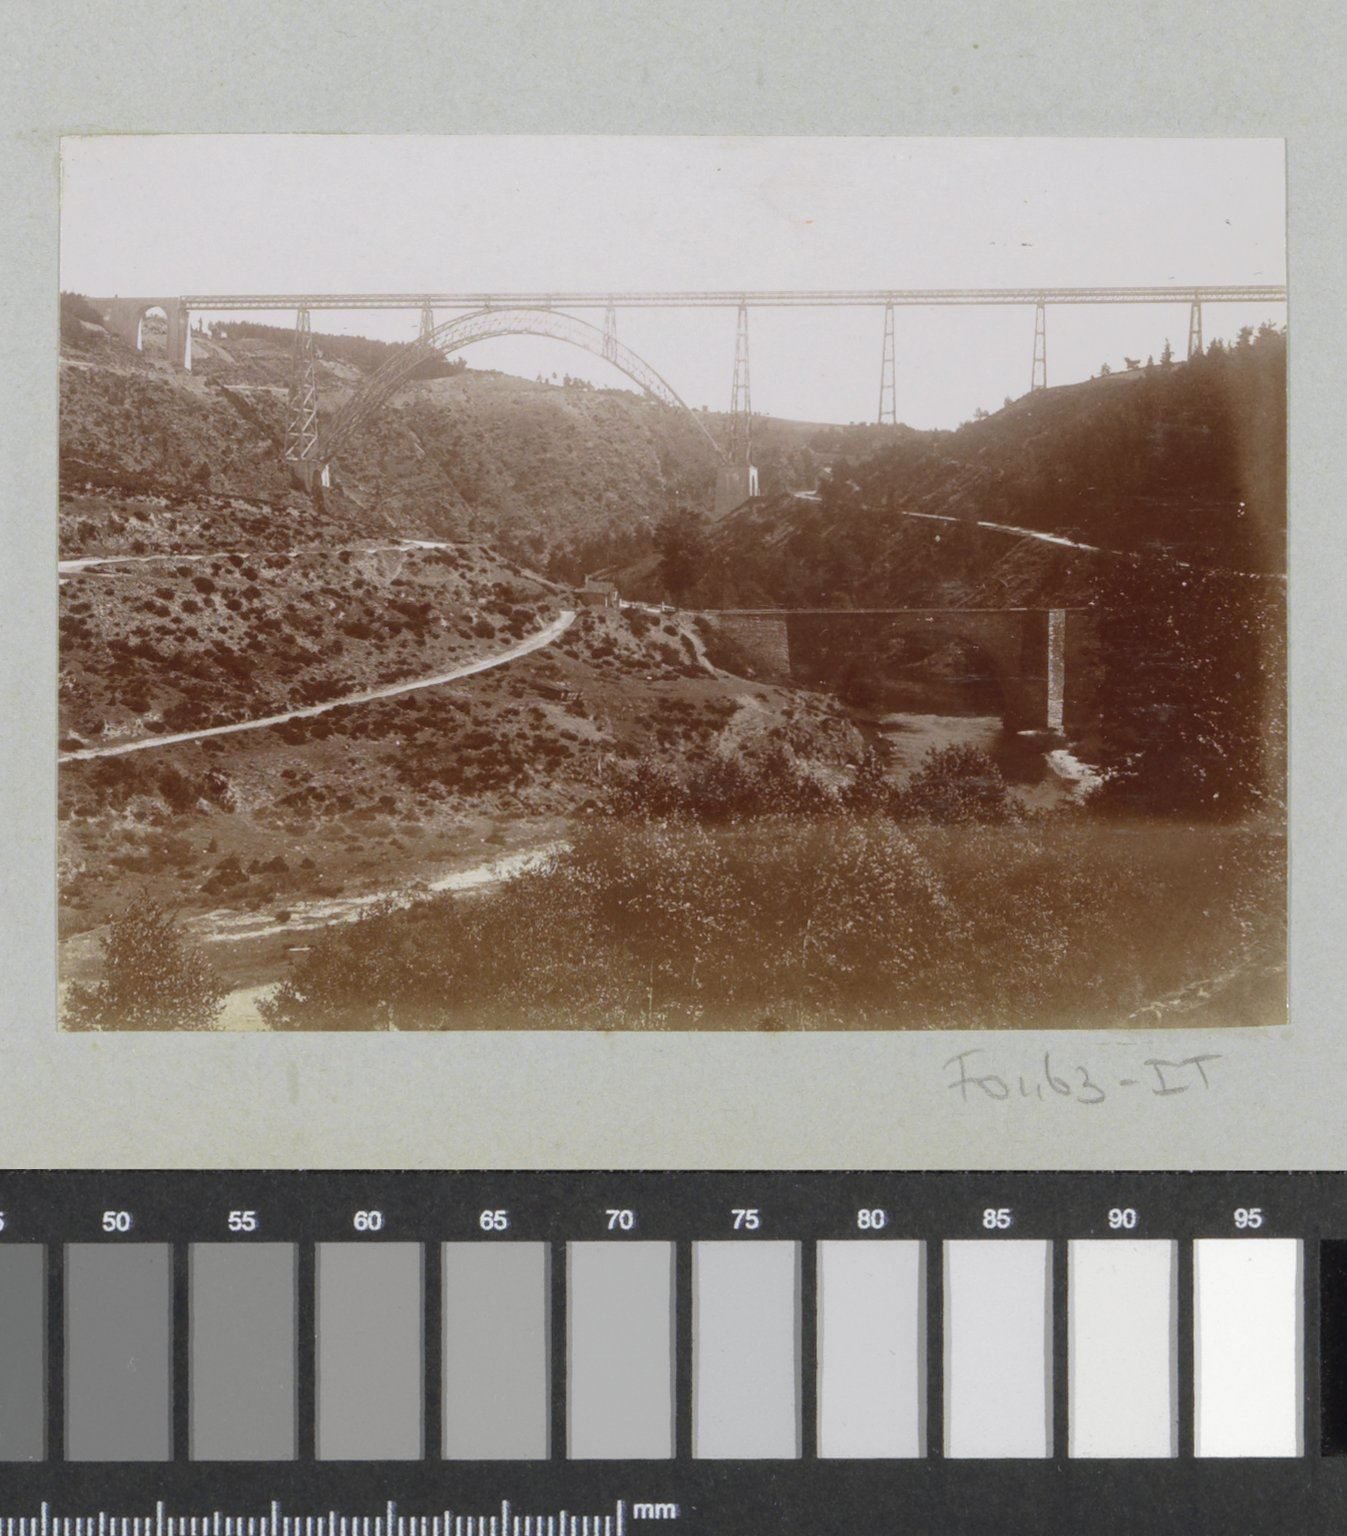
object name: photograph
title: Gezicht op het Viaduc de Garabit bij Ruynes-en-Margeride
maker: delizy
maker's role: manufacturer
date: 1808-1899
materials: paper, photographic support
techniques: gelatin silver print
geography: ruynes-en-margeride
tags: landscape with bridge, viaduct or aqueduct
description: Onderdeel van Fotoalbum van een Franse amateurfotograaf met opnames van uitstapjes in Frankrijk, Spanje, België, Luxemburg en Nederland, de eerste automobielen en autoraces.